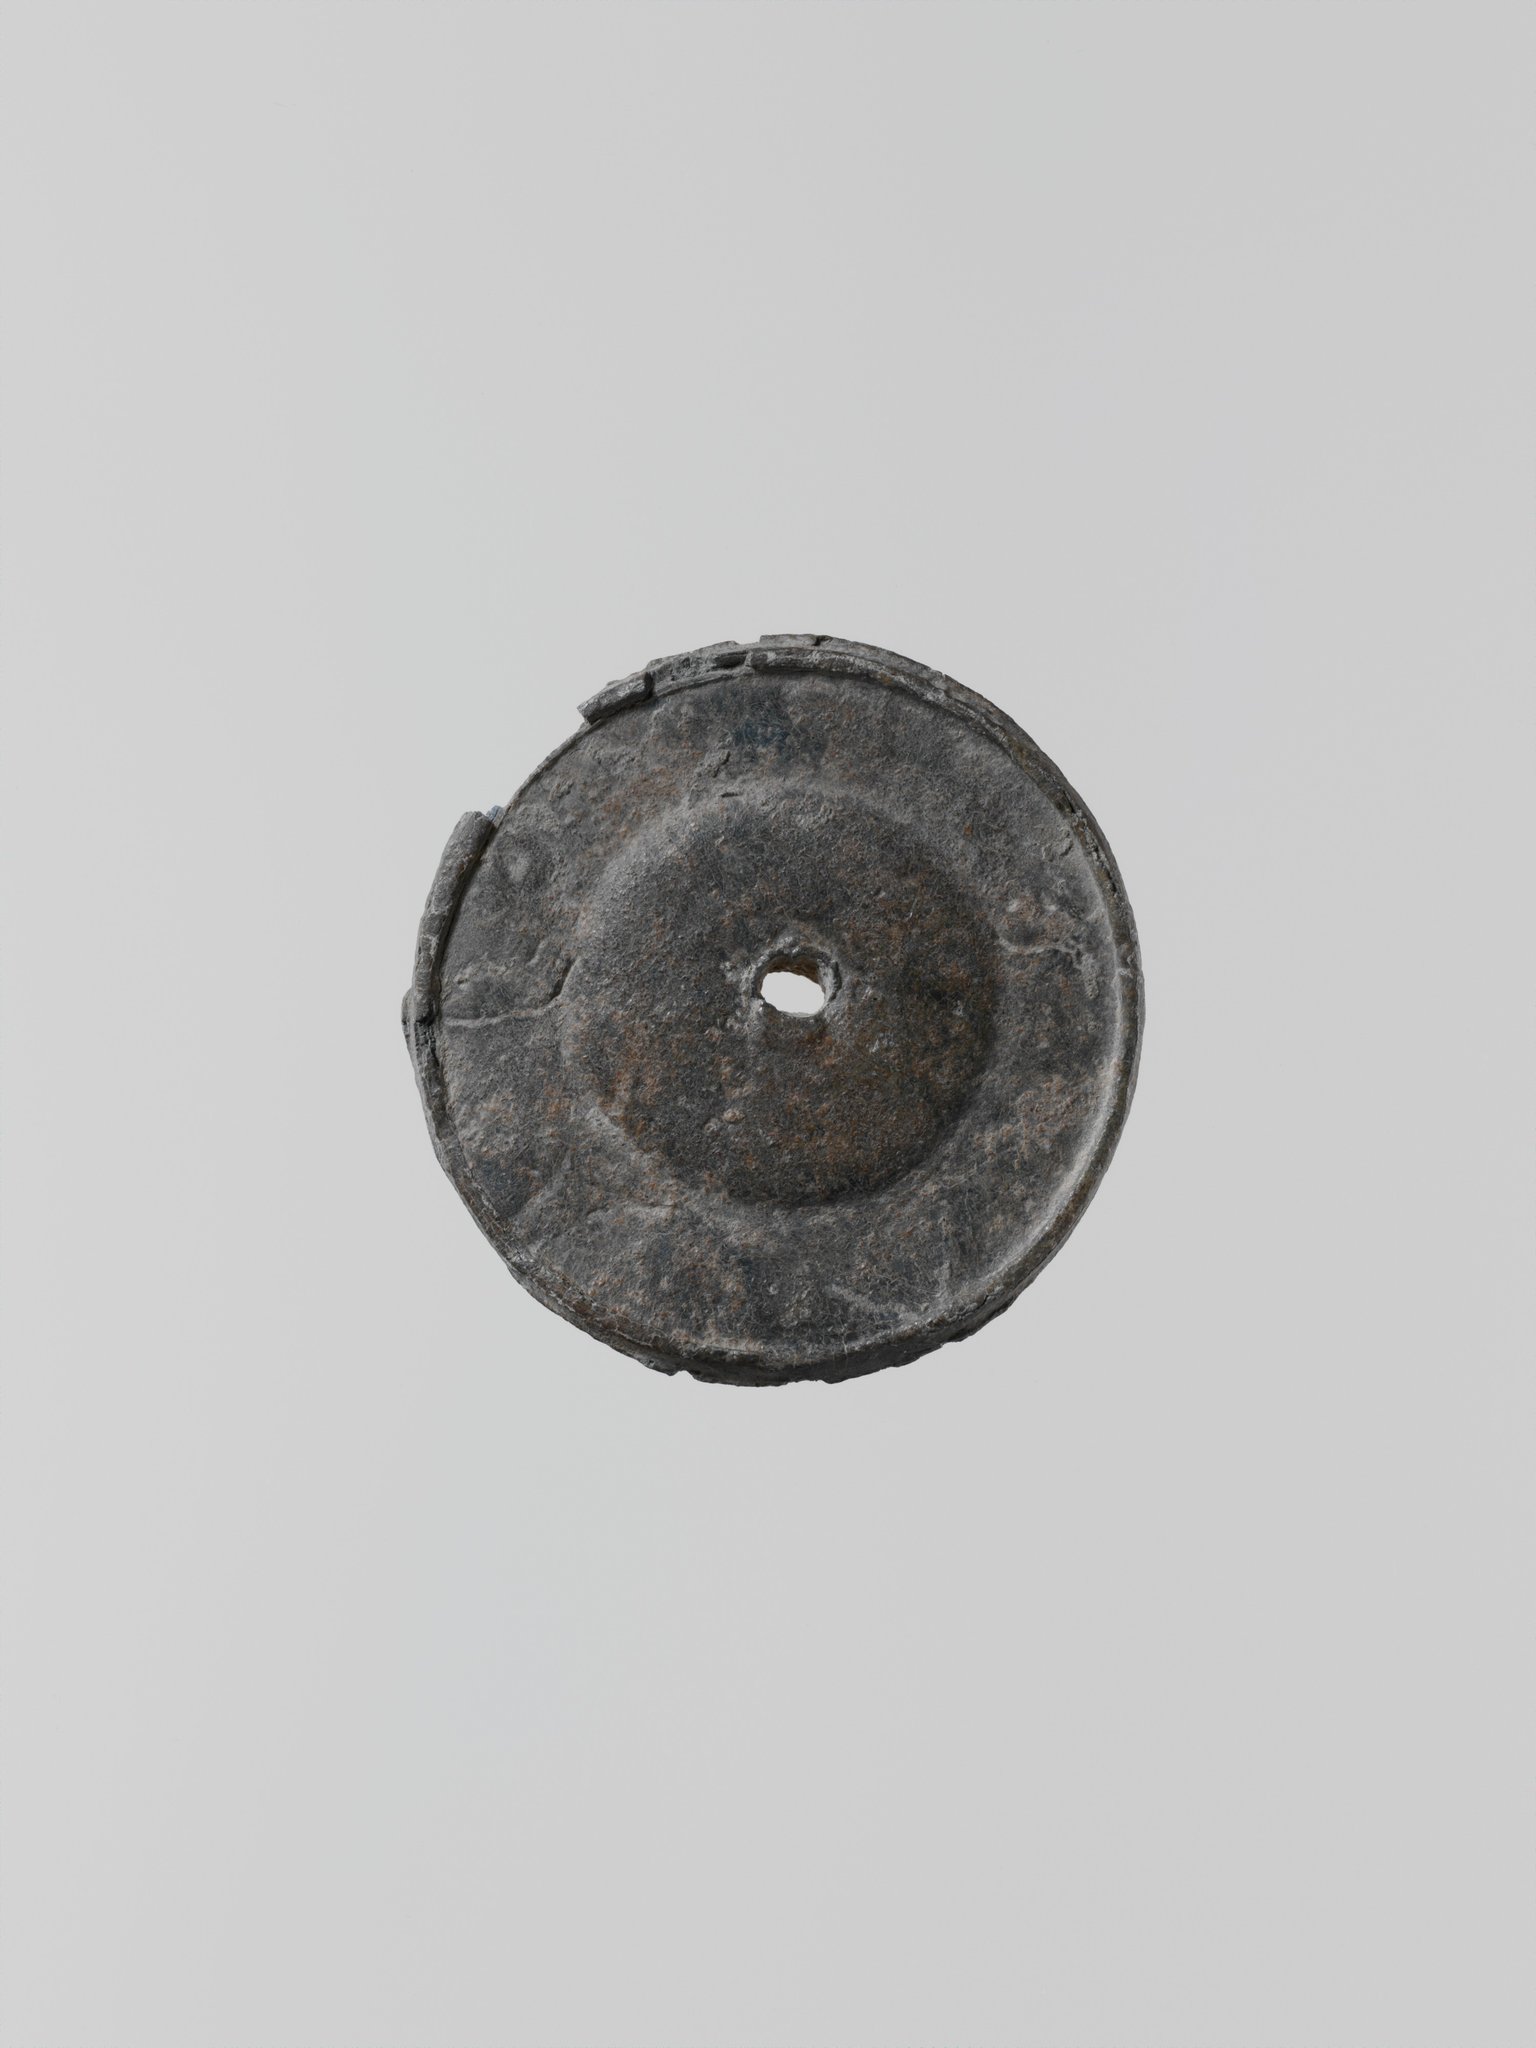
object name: disk, five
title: Lead disk with a hole in the center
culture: greek, laconian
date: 600-401 BCE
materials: lead